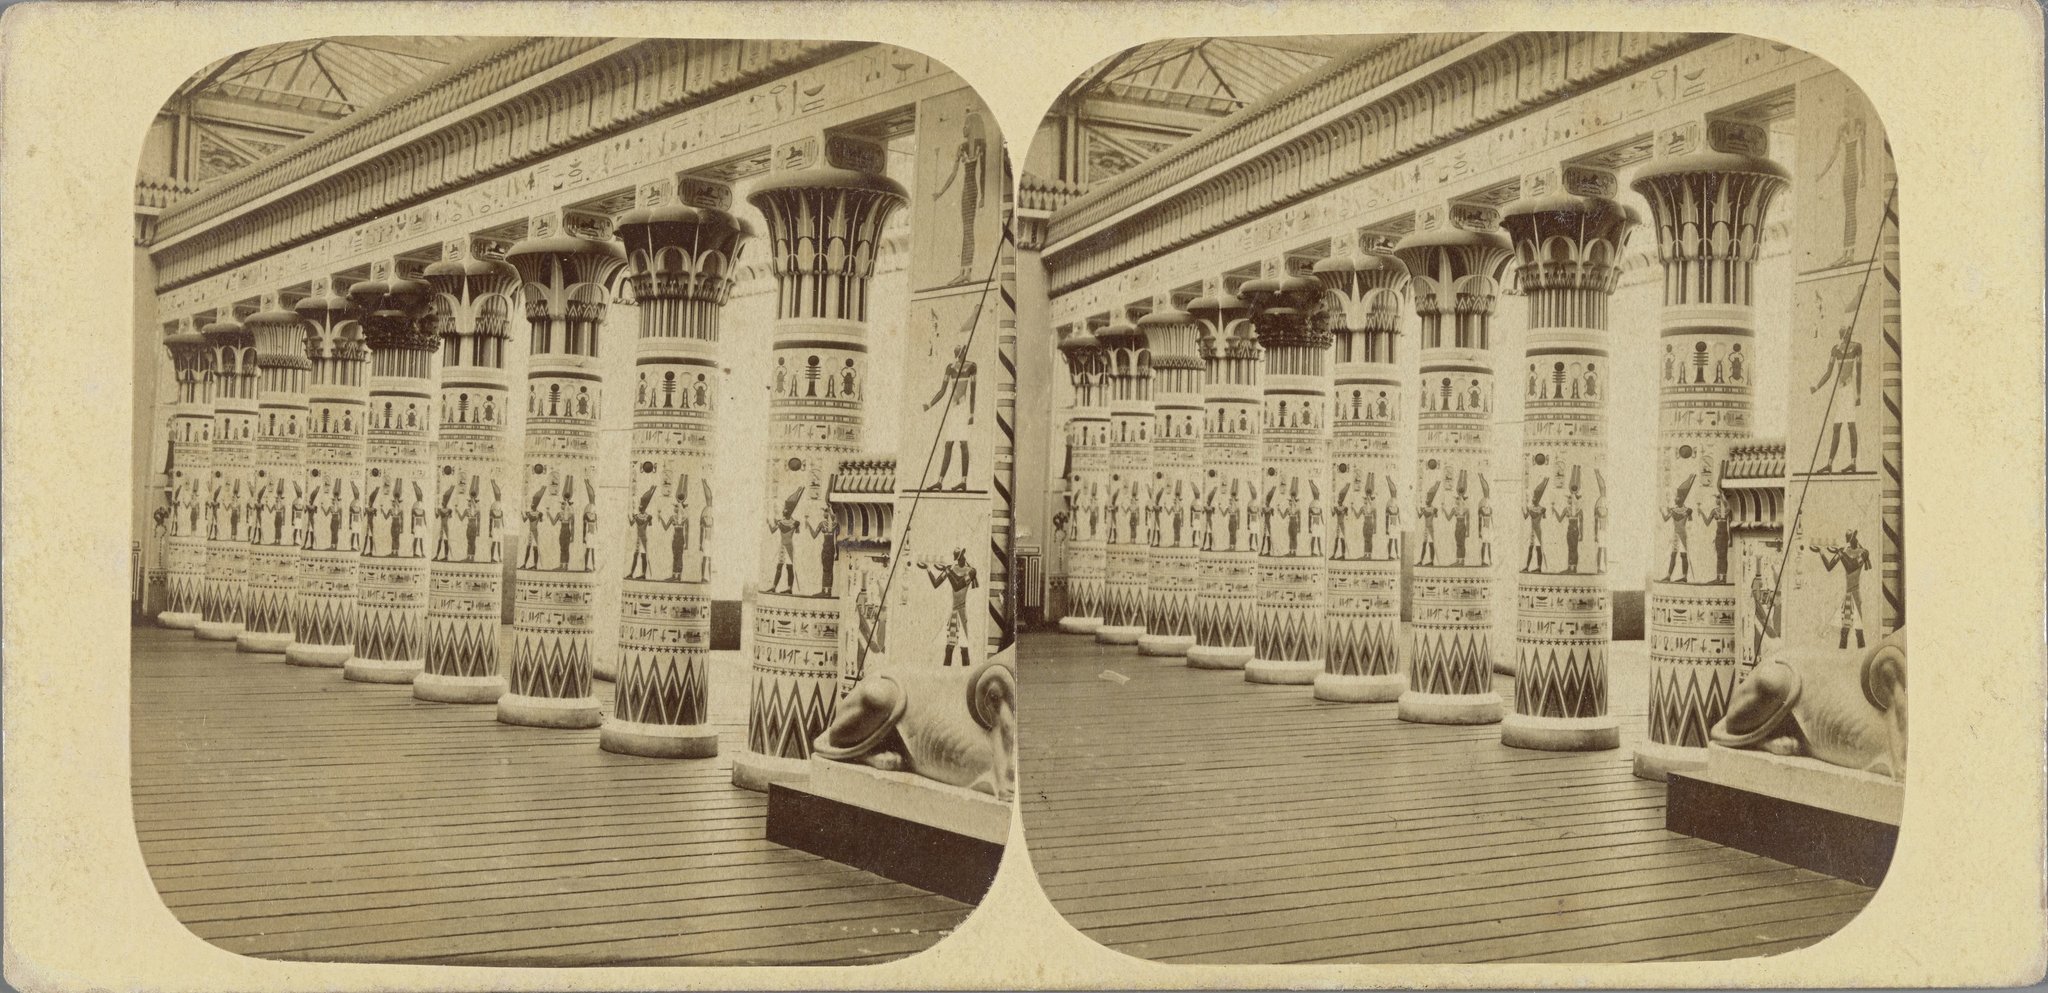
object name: stereograph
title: Crystal Palace. 140. The Philoe Portico. In the inner Egyptian Court.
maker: Anonymous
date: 1870-1890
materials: cardboard, paper, photographic support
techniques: albumen print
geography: crystal palace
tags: colonnade